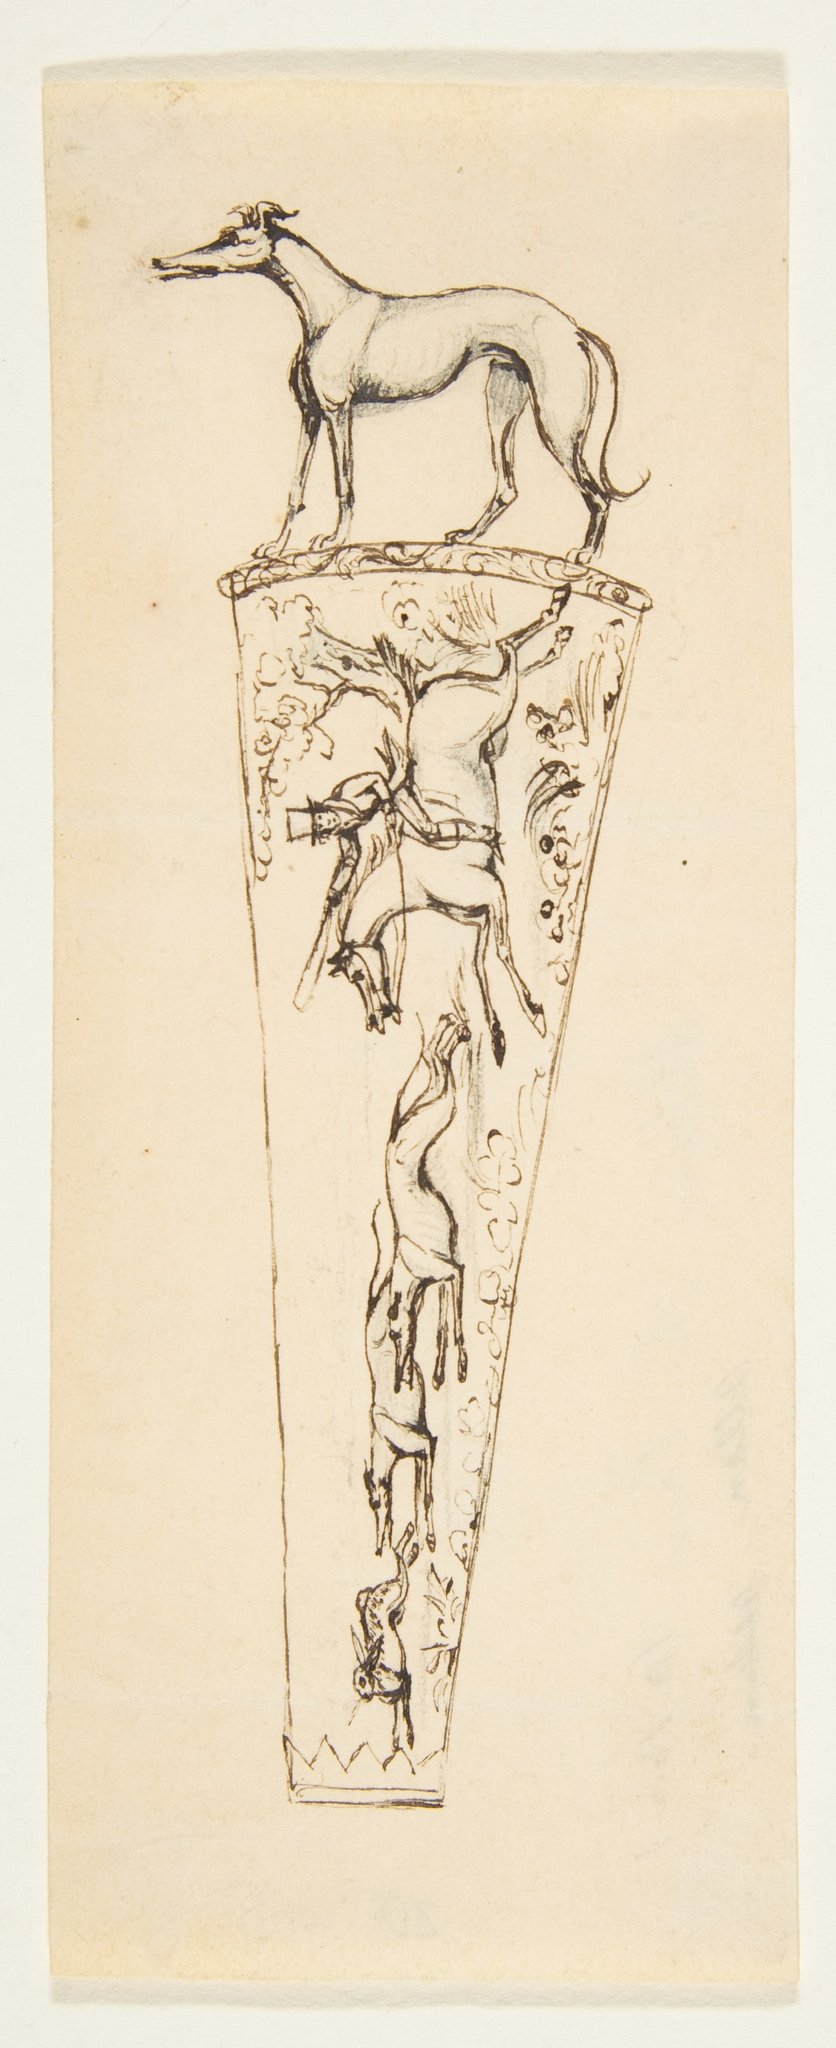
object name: drawing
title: Design for a Vessel with Hunting Scenes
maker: anonymous, french, 19th century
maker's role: artist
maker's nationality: french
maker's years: 1800-1900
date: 1801-1900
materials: graphite, ink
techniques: pen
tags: hunting,dogs,horses